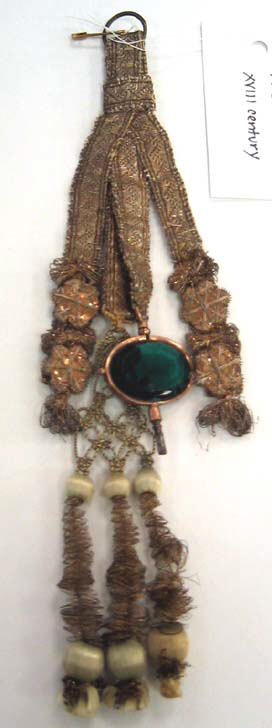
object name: fob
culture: french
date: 1701-1800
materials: glass, metal thread, silk